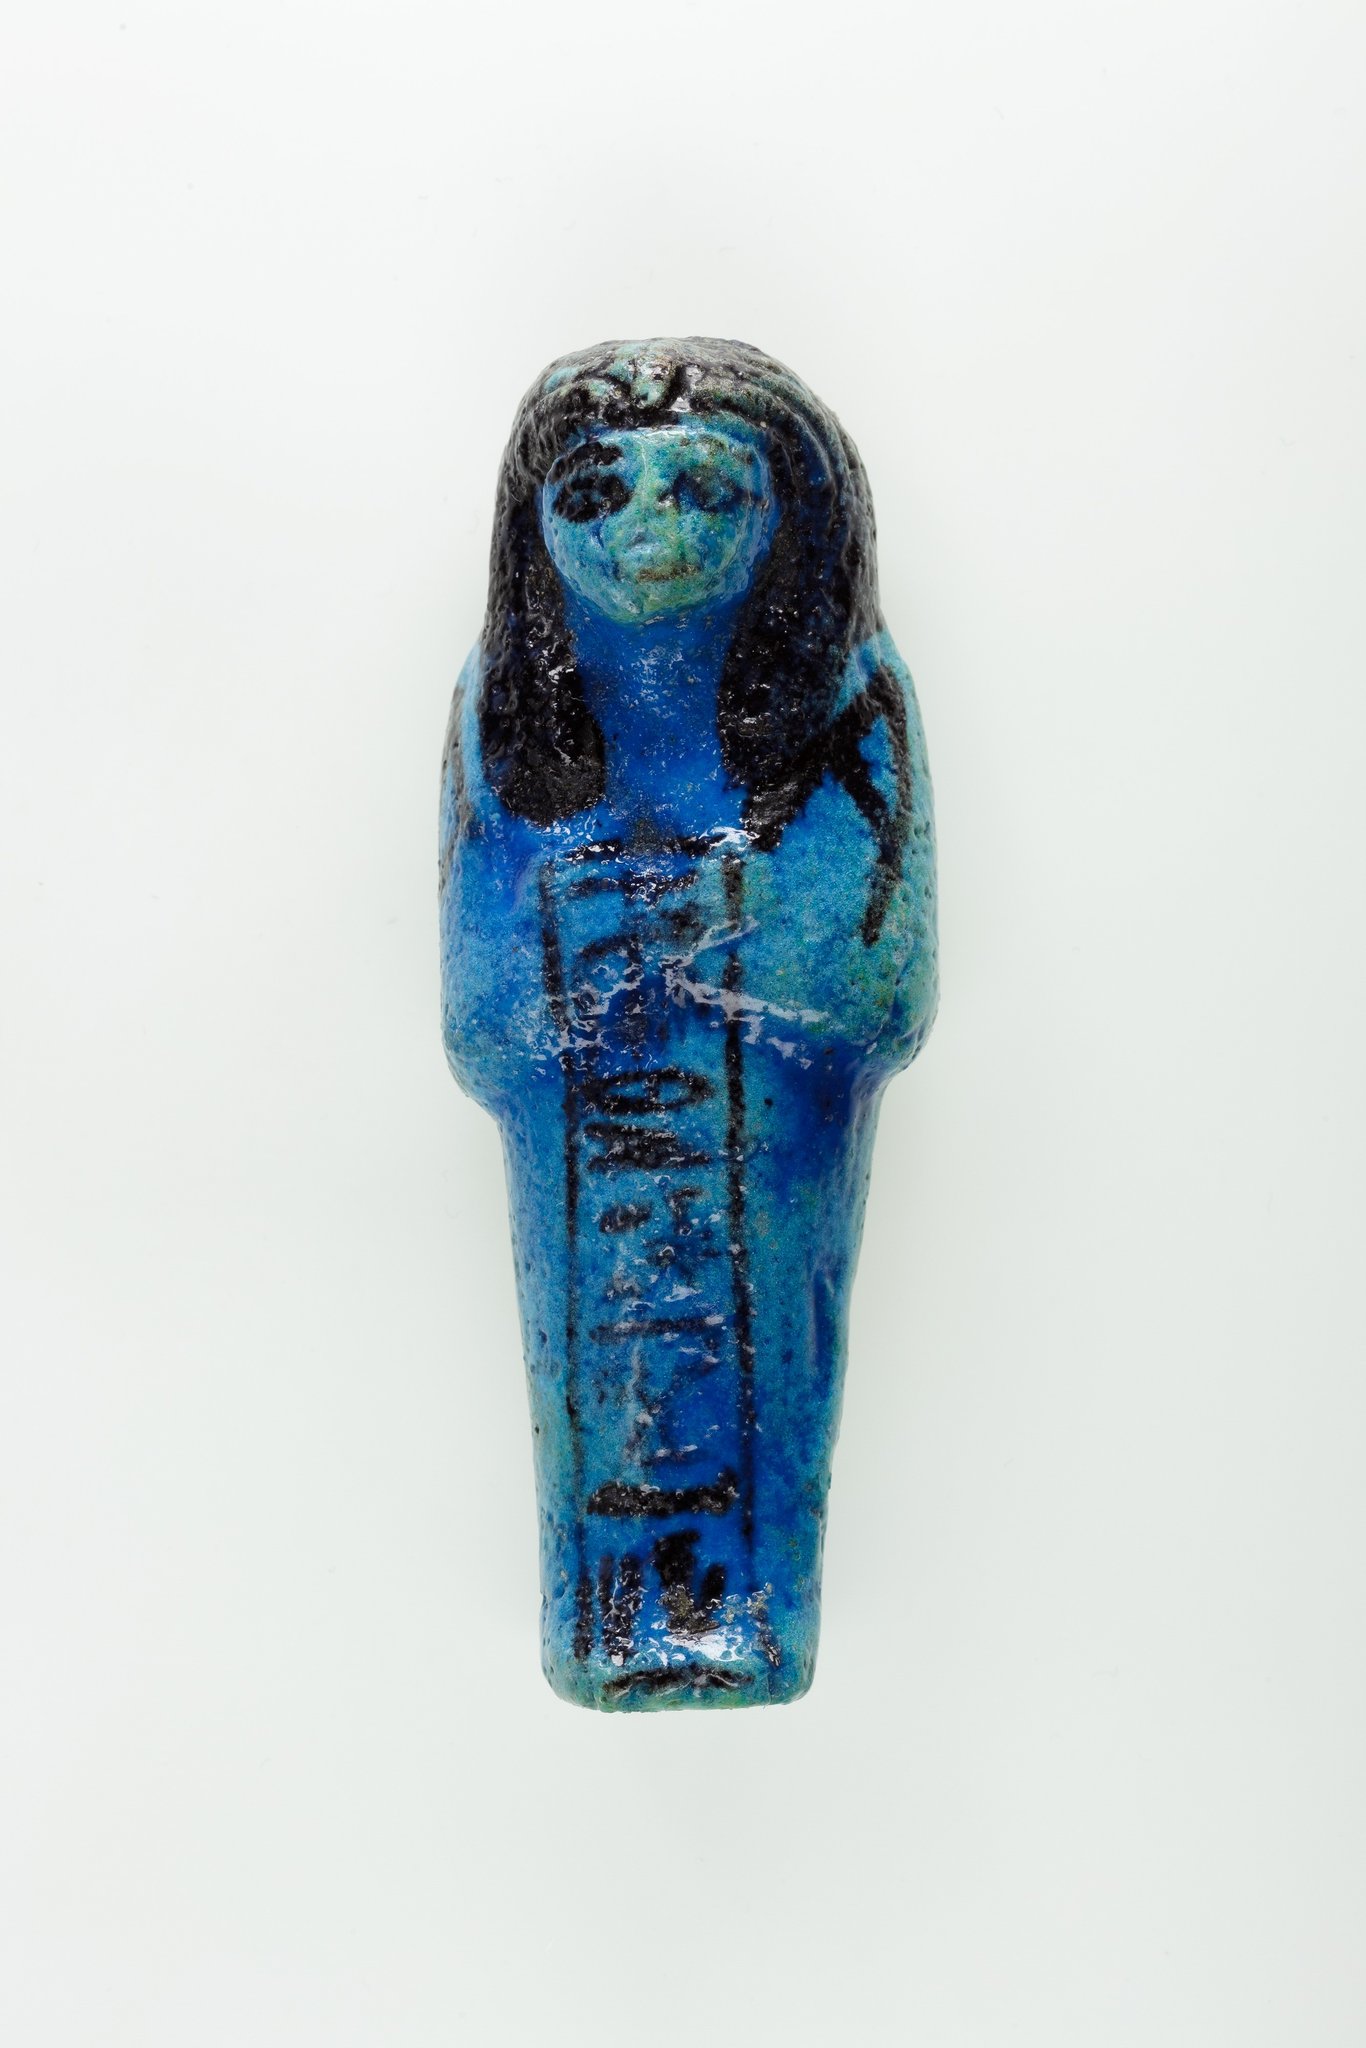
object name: shabti, worker, nauny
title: Worker Shabti of Nauny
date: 1050 BCE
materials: faience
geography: egypt